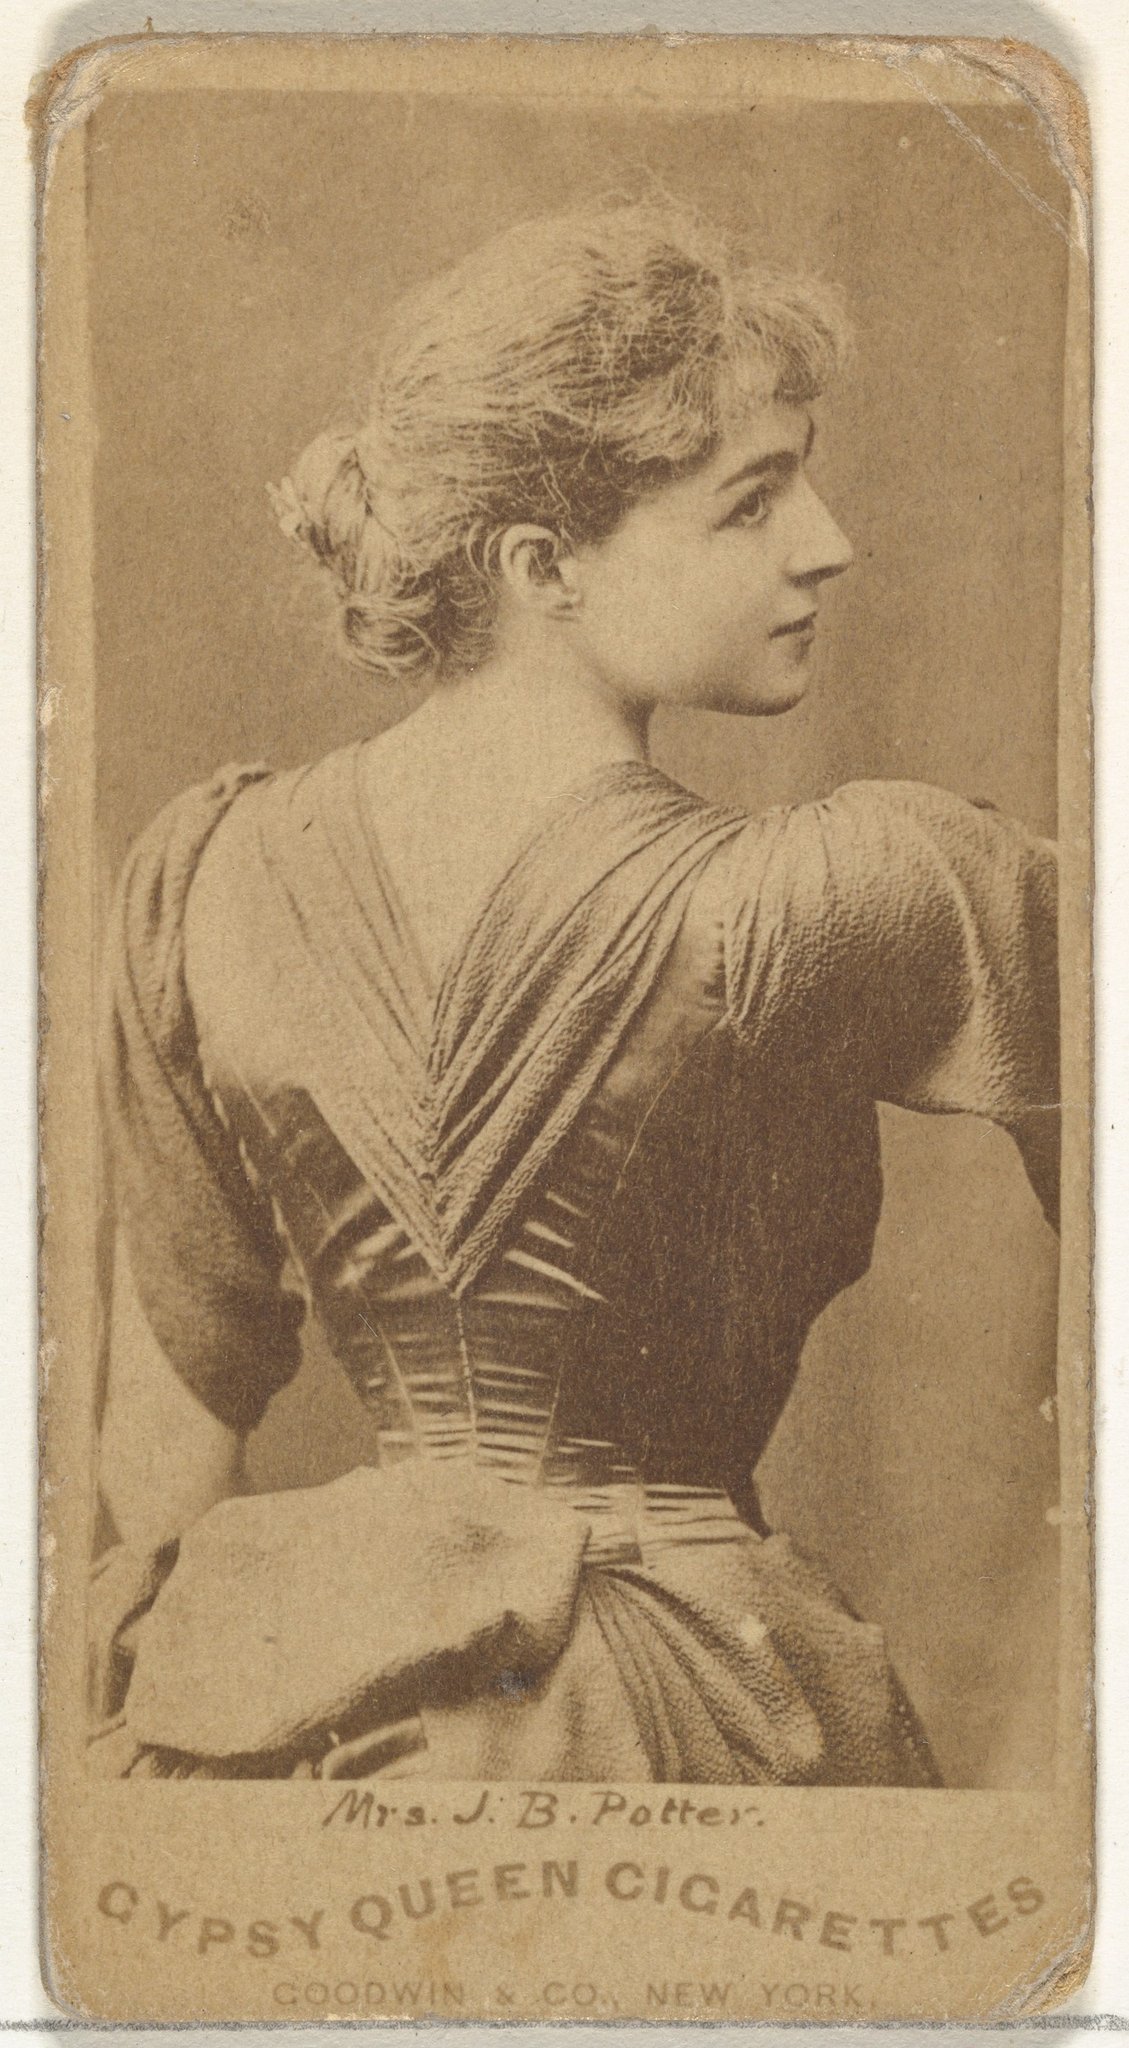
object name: photograph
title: Mrs. James Brown Potter, from the Actors and Actresses series (N171) for Gypsy Queen Cigarettes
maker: goodwin & company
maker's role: publisher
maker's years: 1850-1950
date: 1886-1890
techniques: albumen silver print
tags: portraits,women,actresses